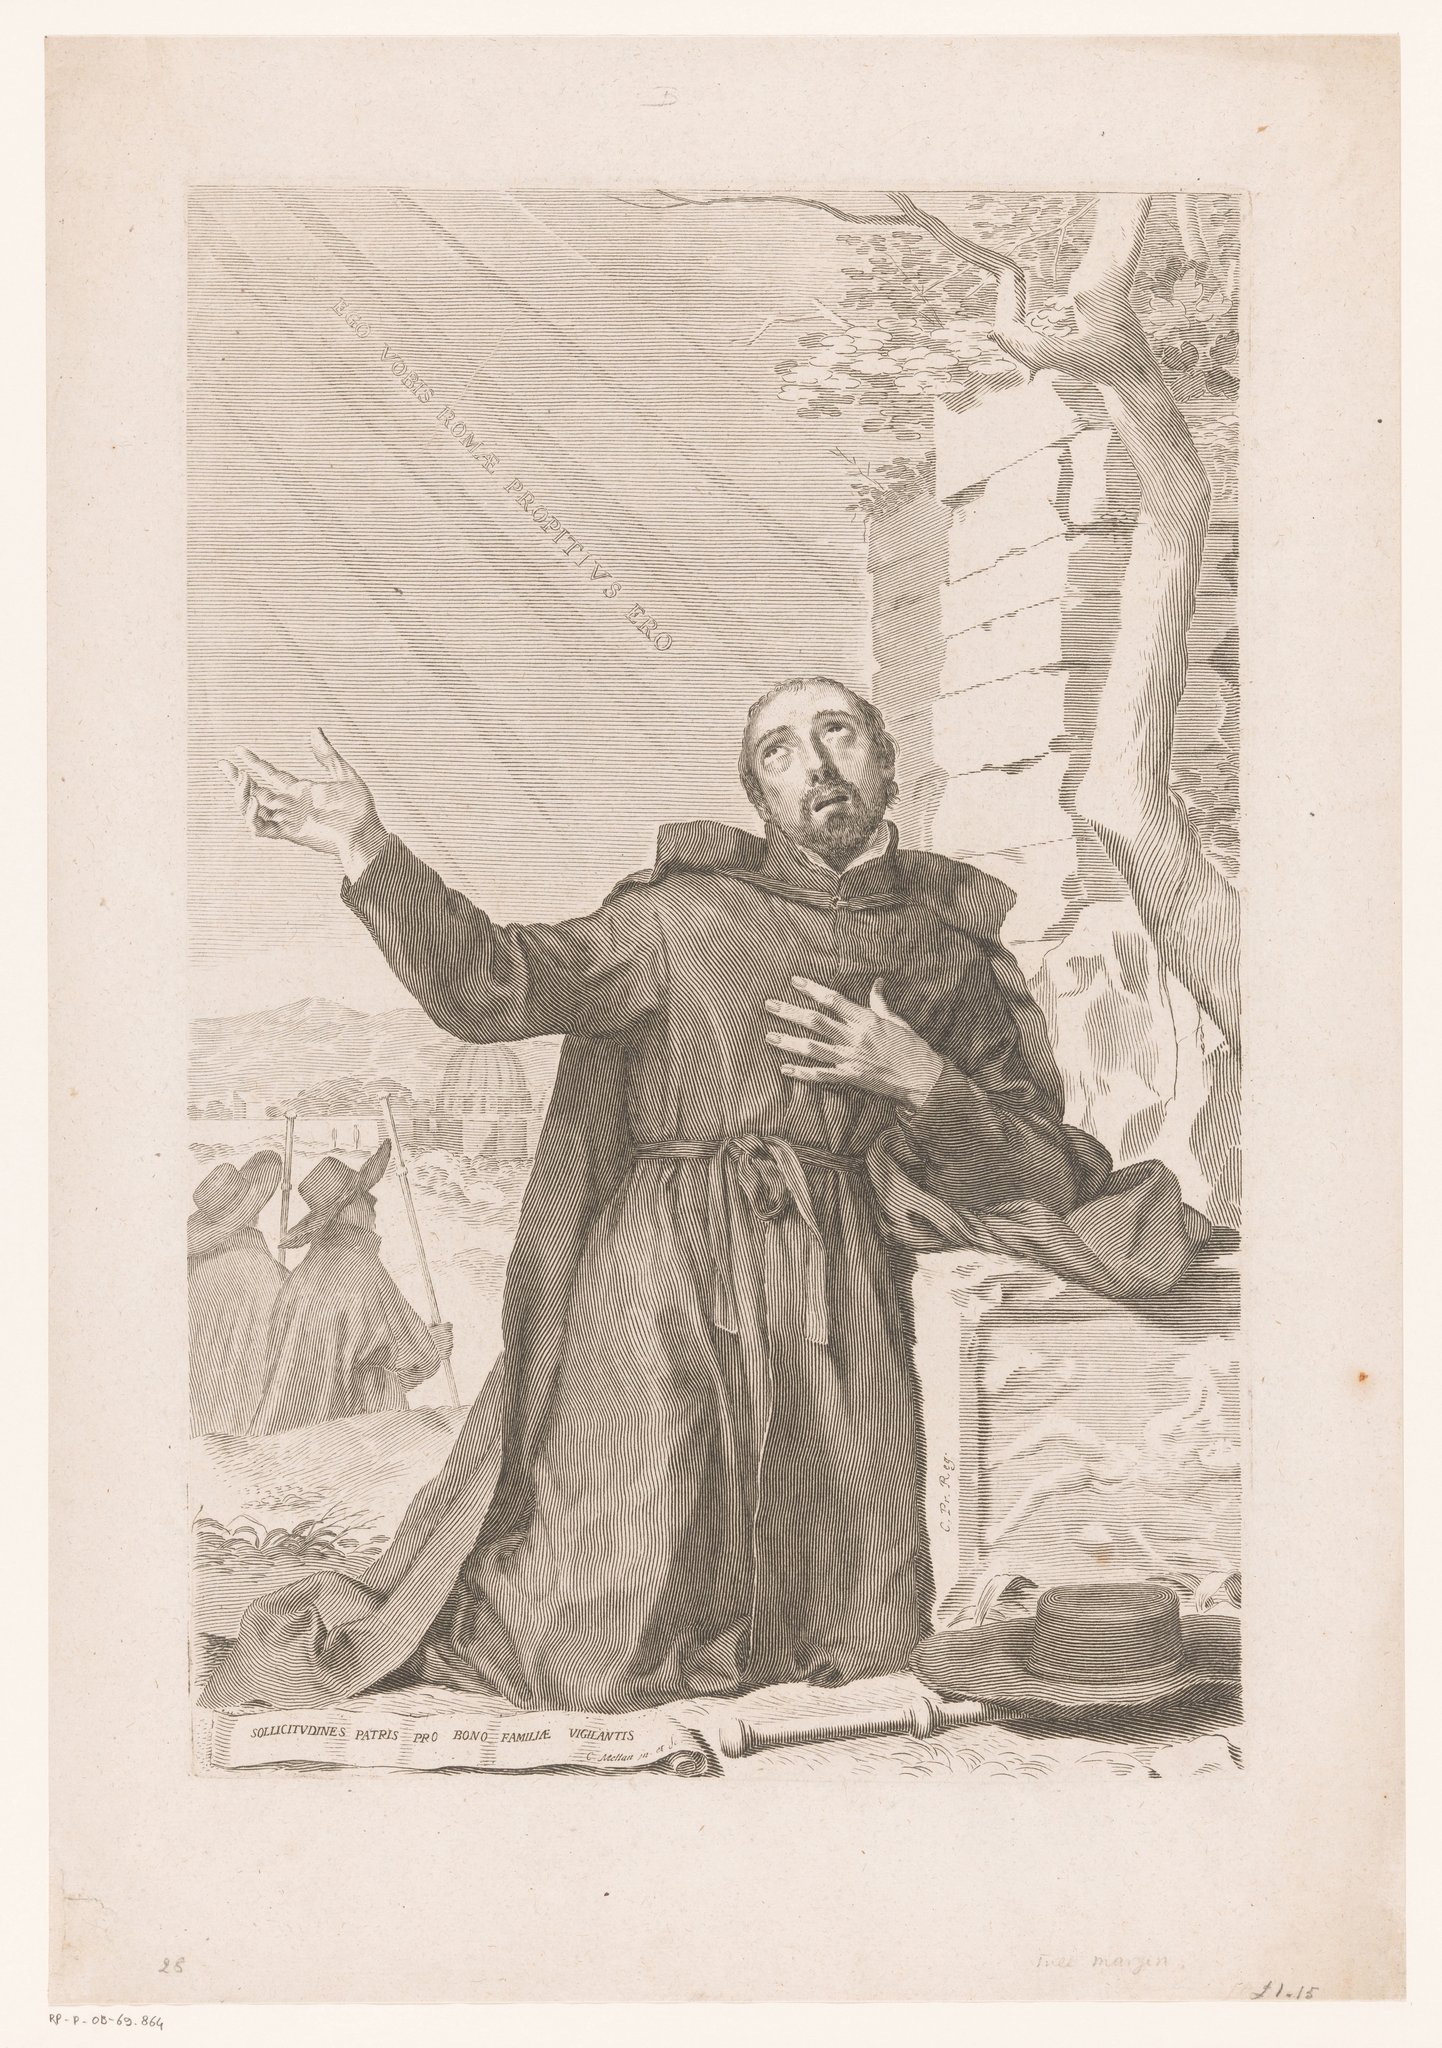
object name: print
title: H. Ignatius van Loyola in extase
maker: claude mellan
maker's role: draughtsman, print maker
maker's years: 1598-1688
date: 1608-1688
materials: paper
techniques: engraving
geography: france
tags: rome, clergyman, historical persons, pilgrimage, pilgrim(s) under way, visions of st. ignatius of loyola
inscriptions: collector's mark: Lugt 2228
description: De heilige Ignatius van Loyola, knielend in extase voor een blok met reliëf. Op de achtergrond links lopen pelgrims naar Rome.